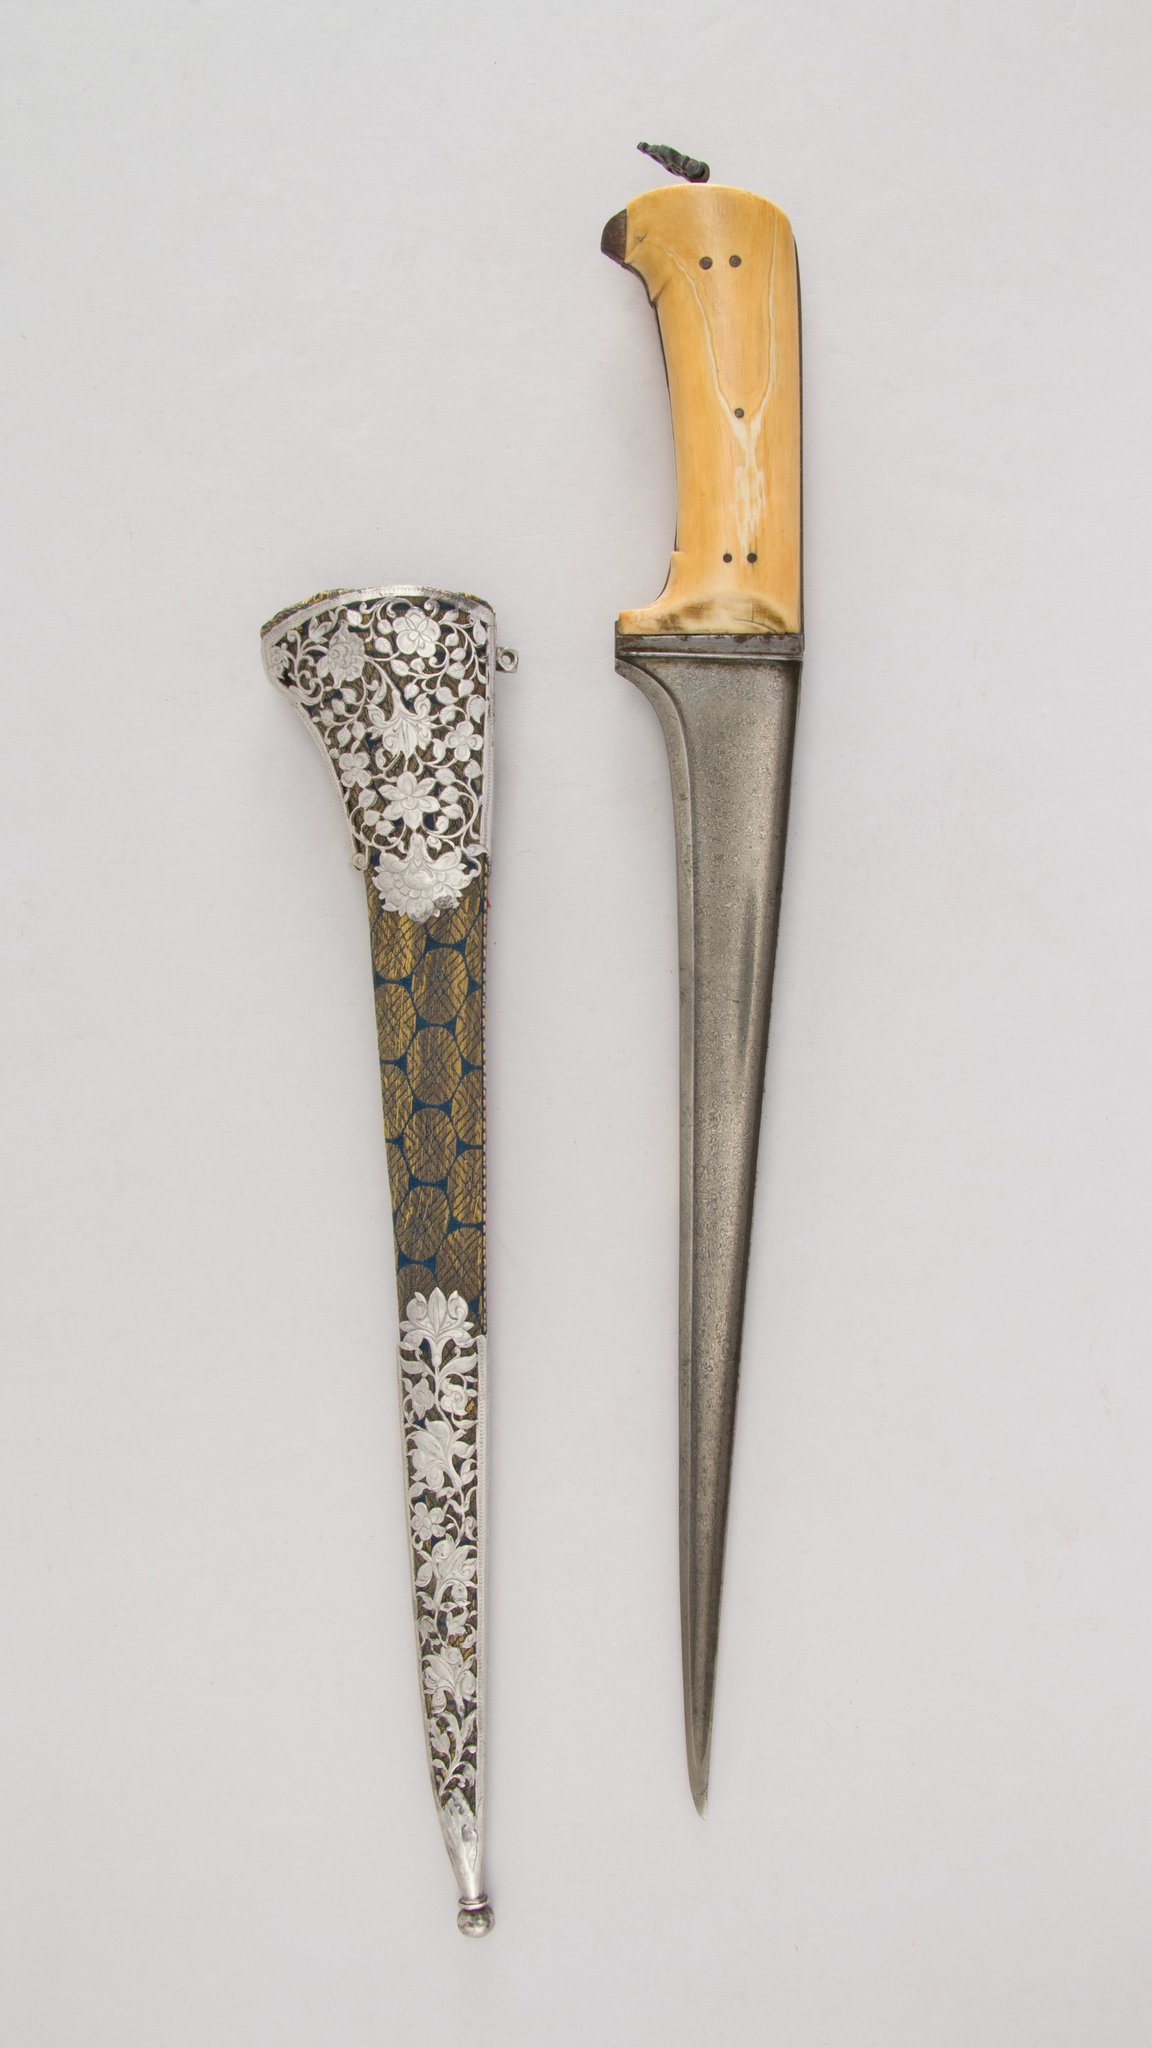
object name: dagger pesh kabz with sheath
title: Dagger (Pesh-kabz) with Sheath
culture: indian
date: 1701-1900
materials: gold, ivory, silk, silver, steel, velvet, wood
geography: india